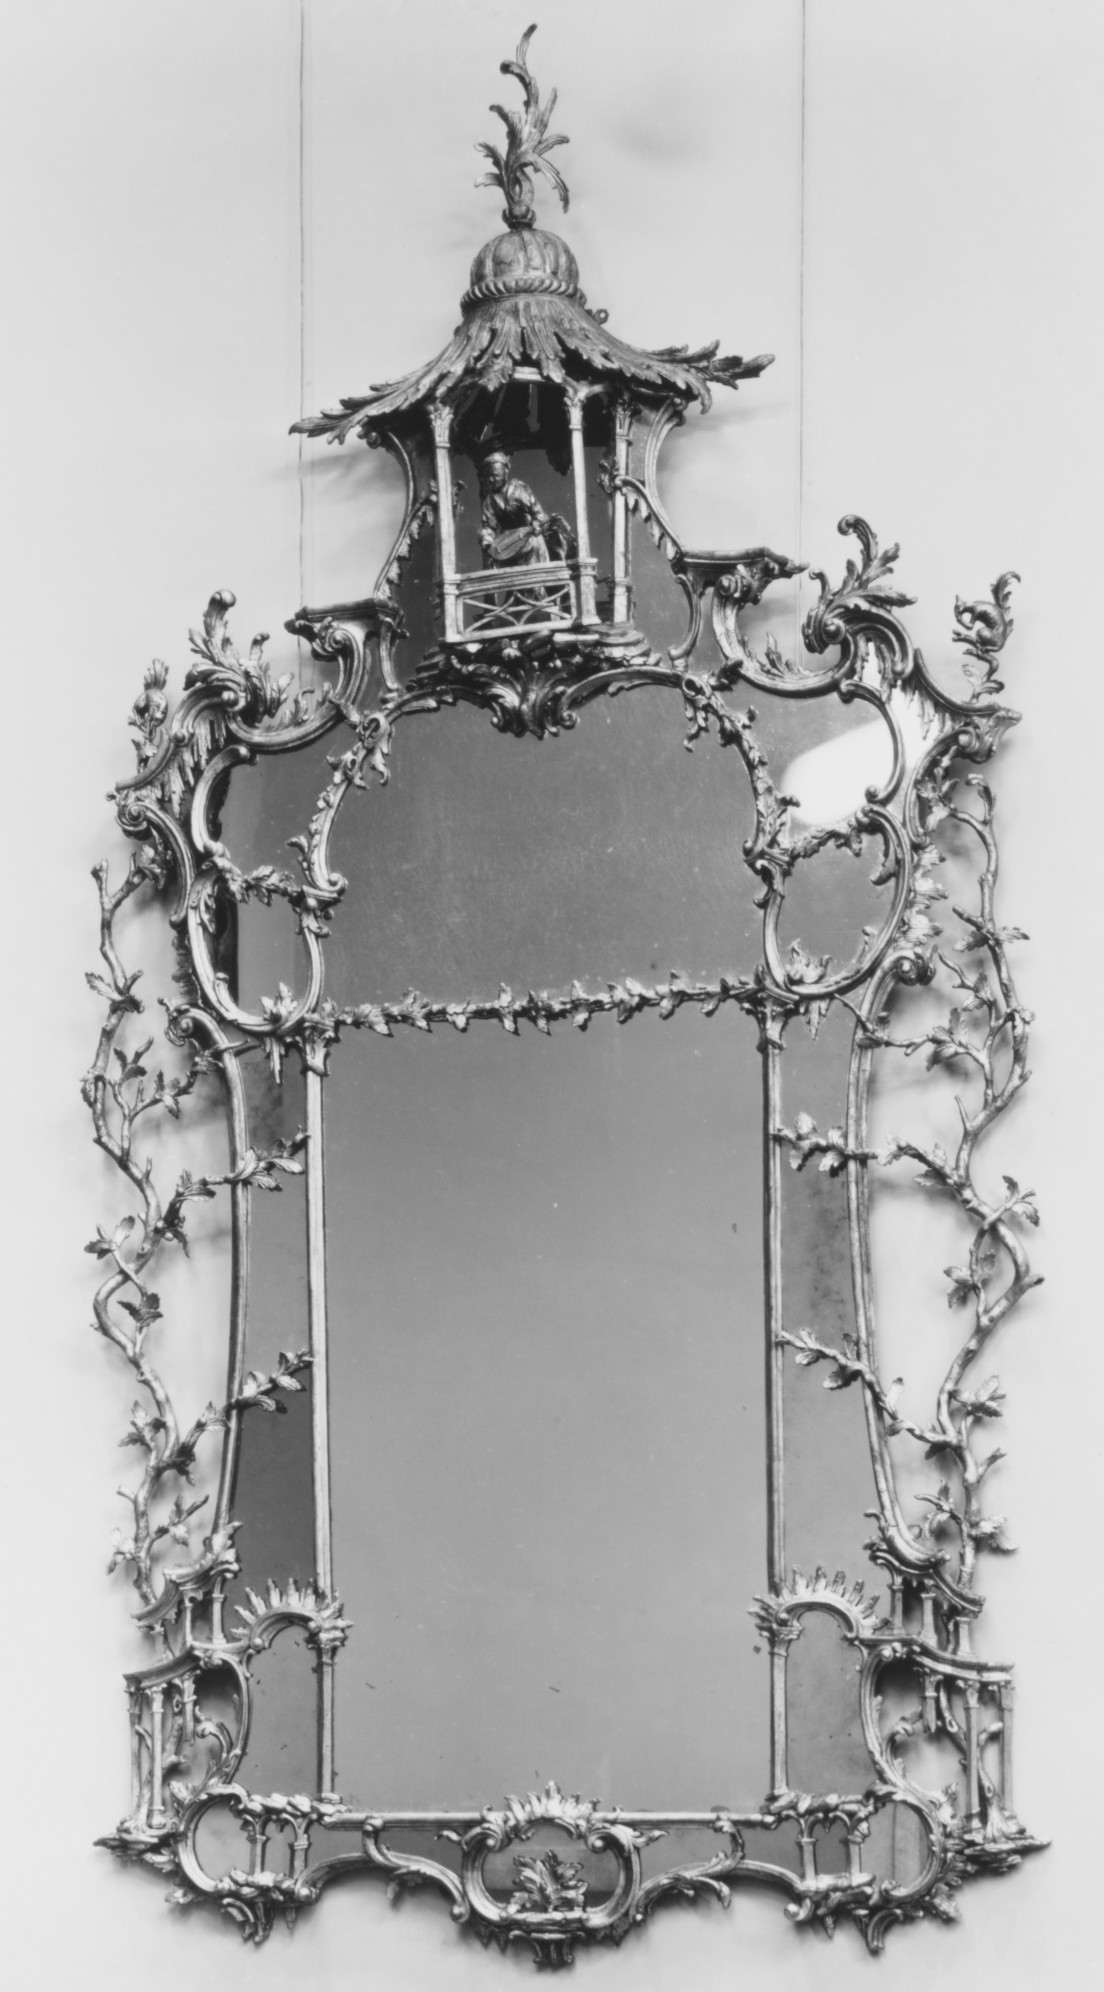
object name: pier glass mirror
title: Pier glass mirror (one of a pair)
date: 1760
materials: gilt, glass, wood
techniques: carving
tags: chinoiserie